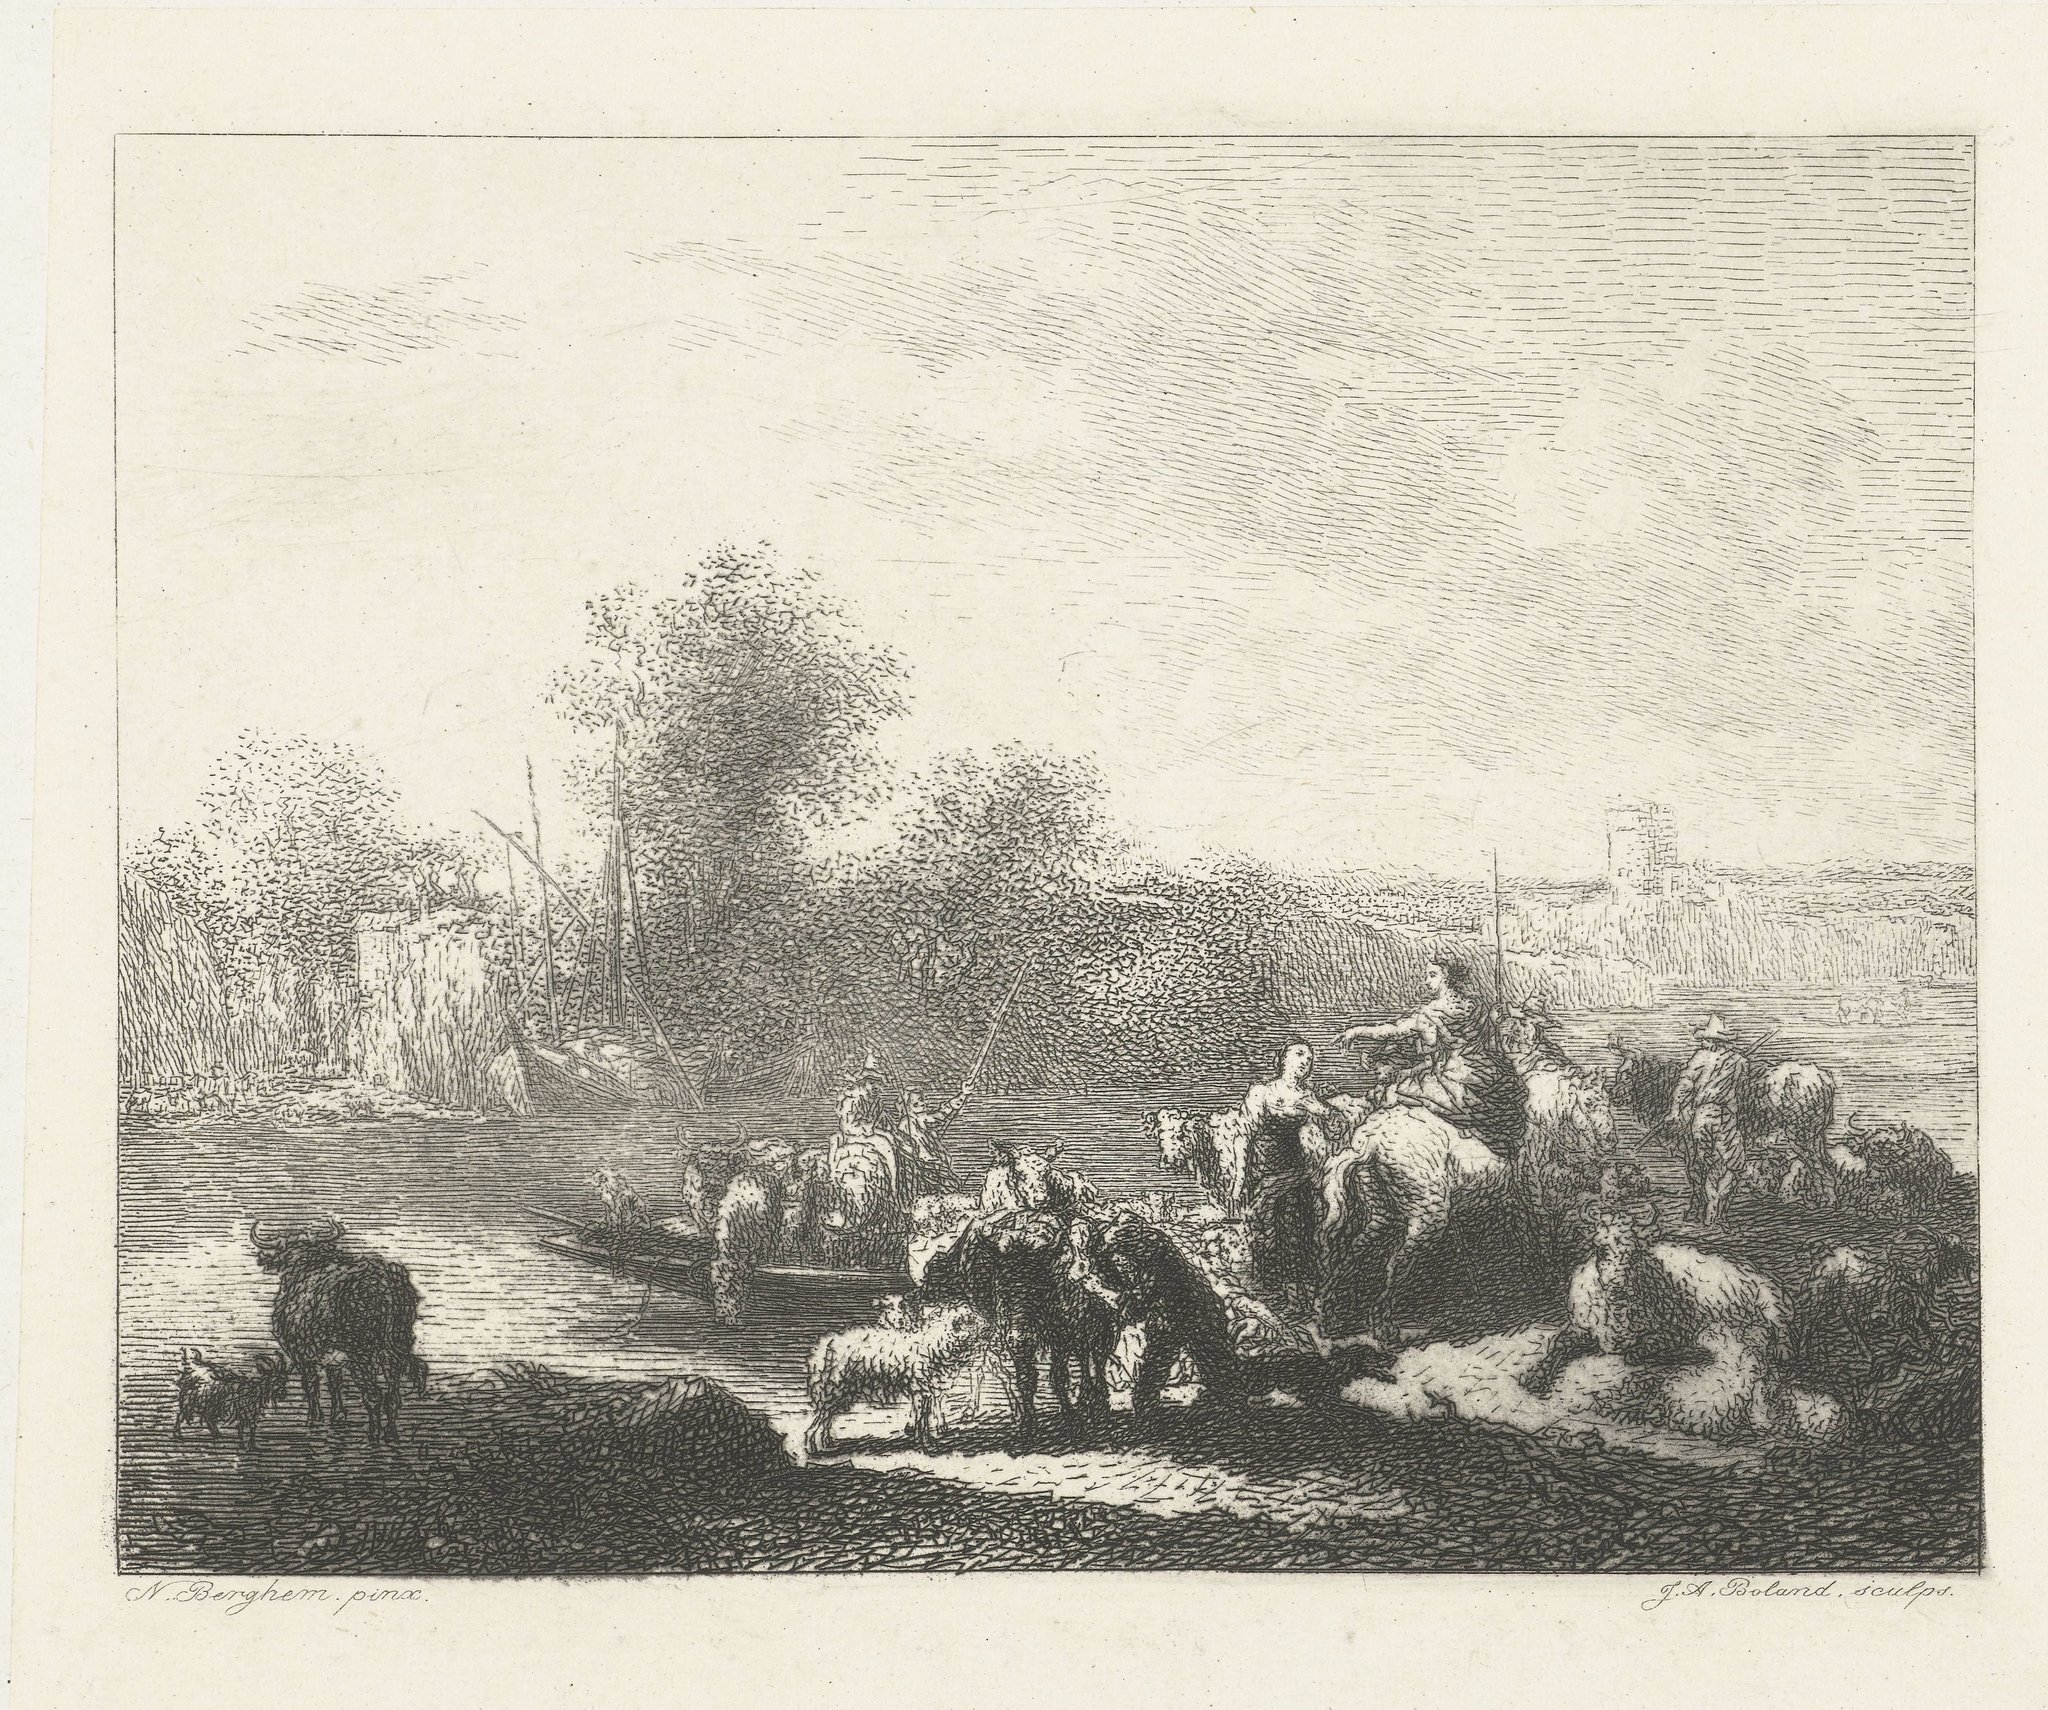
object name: print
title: Het pontveer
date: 1875-1876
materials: paper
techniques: etching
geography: amsterdam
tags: ferry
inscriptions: collector's mark: Lugt 2228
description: Reproductie van een schilderij uit de collectie van het Rijksmuseum Amsterdam, SK-A-31. Prent afkomstig uit: Brink, J. ten (et al.). Het Rijksmuseum te Amsterdam: [25] etsen van J.A. Boland. Haarlem: J.M. Schalekamp, [1875-1876] (13 A 20).